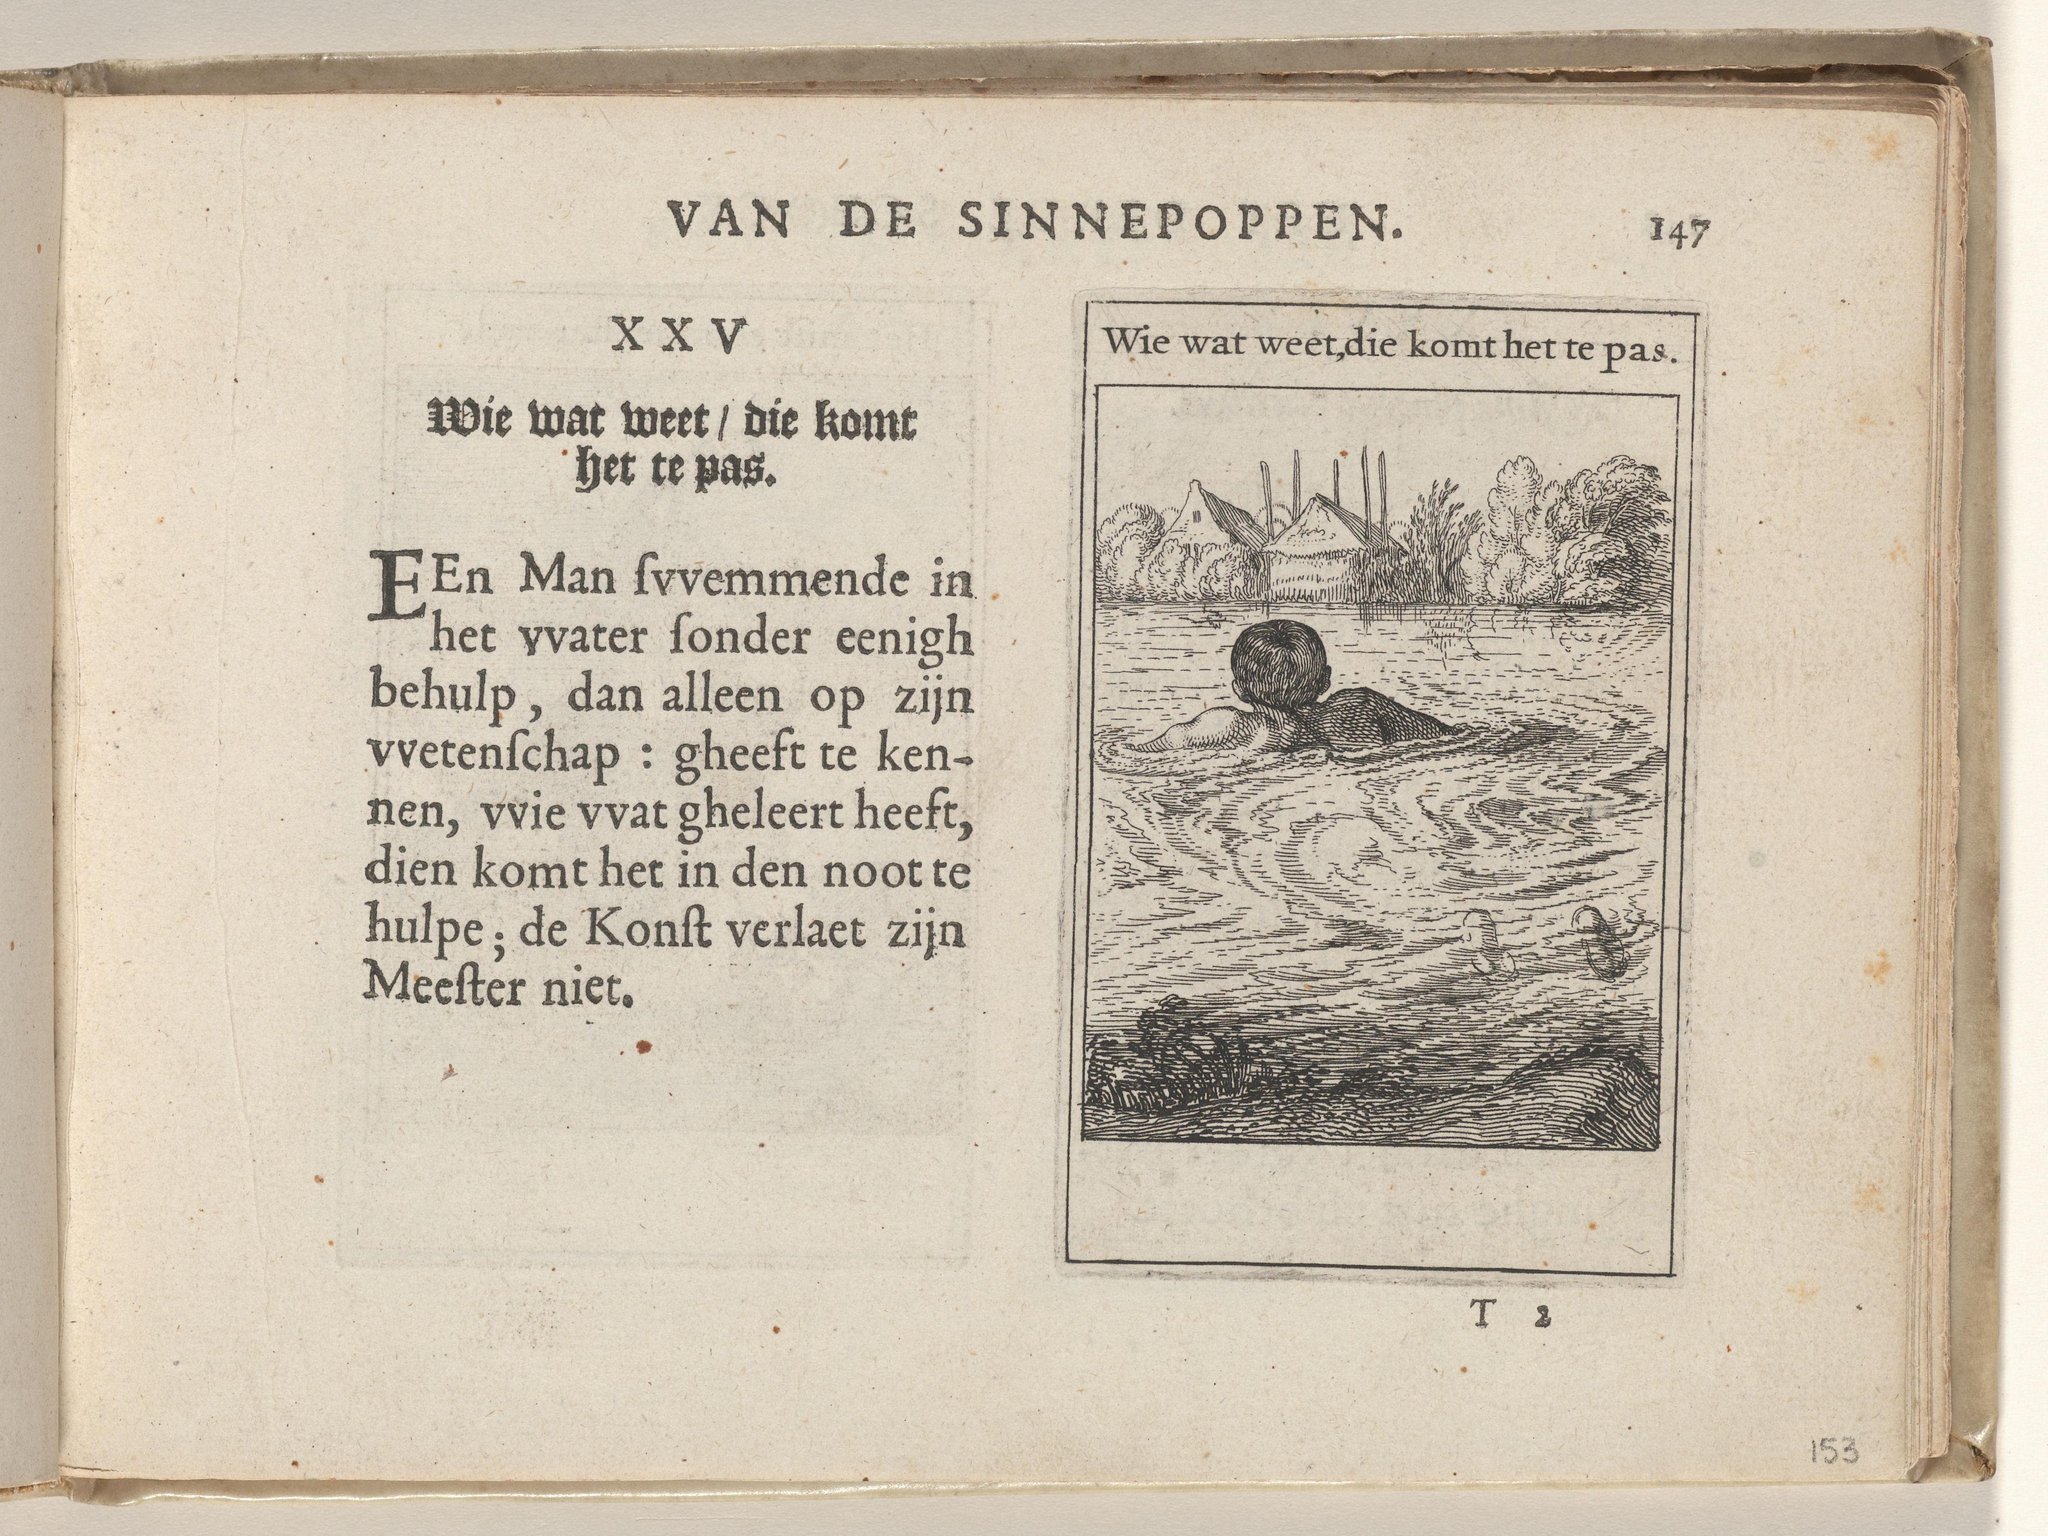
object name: album leaf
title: XXV Wie wat weet, die komt het te pas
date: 1614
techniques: engraving, printing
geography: amsterdam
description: XXV Wie wat weet, die komt het te pas. Derde schok. Onderdeel van 'Sinnepoppen', R. Visscher, 1614.